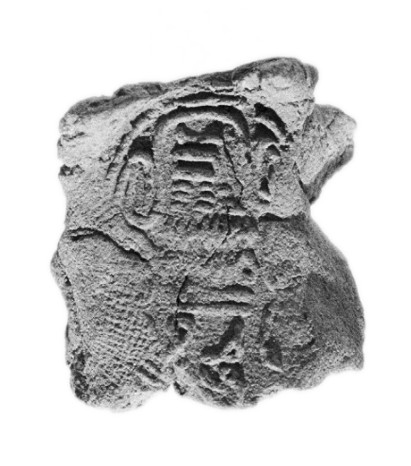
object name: sealing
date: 1981-1640 BCE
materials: mud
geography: egypt